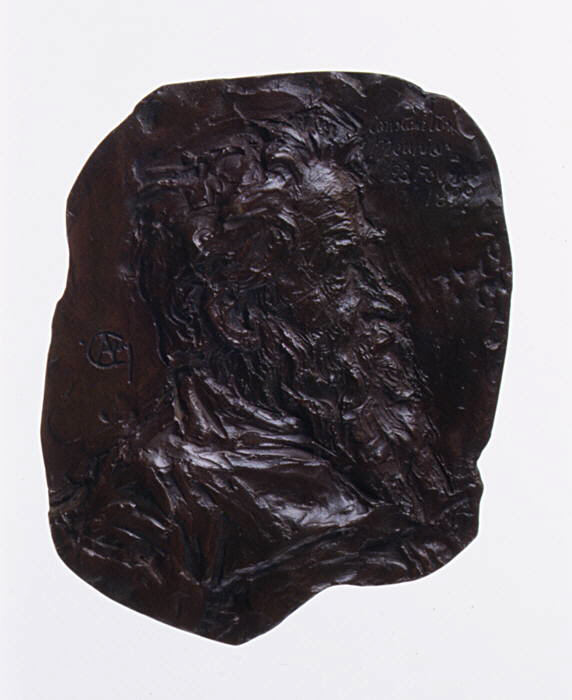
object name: relief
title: Constantin Meunier, Sculptor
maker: alexandre-louis-marie charpentier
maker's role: artist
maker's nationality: french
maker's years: 1856-1909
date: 1899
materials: bronze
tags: human figures